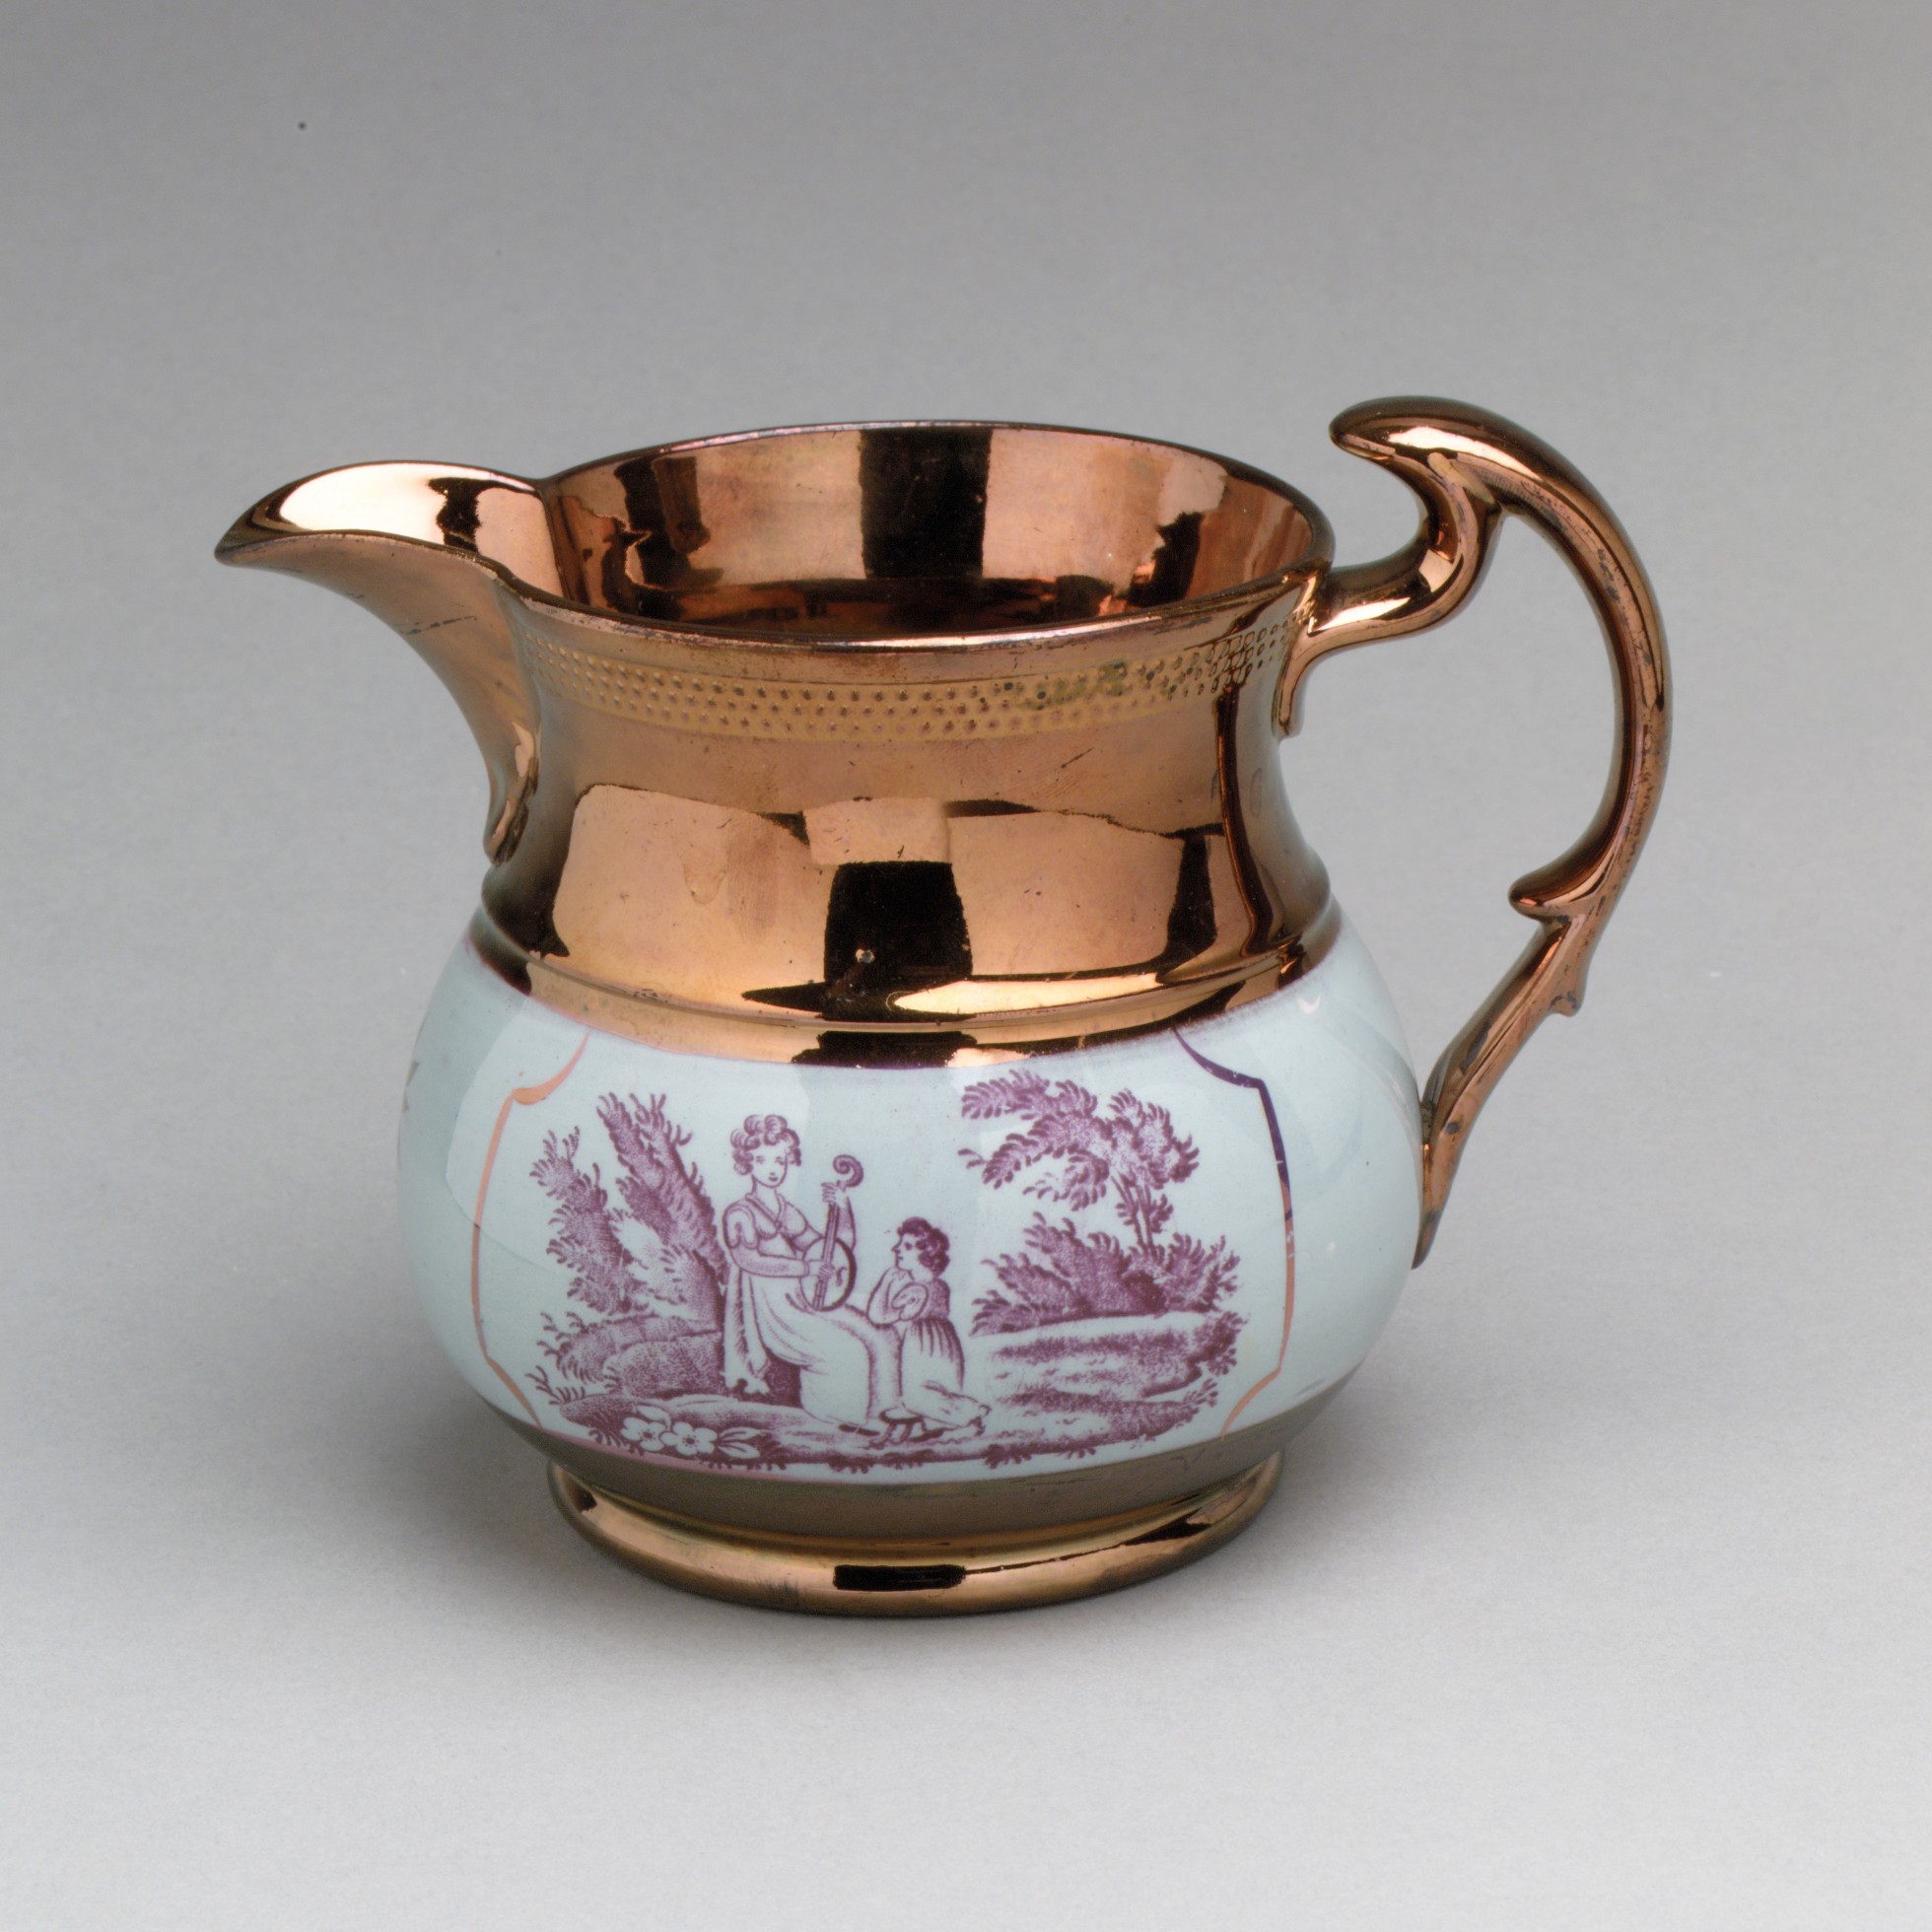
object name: pitcher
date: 1801-1900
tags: musical instruments,women